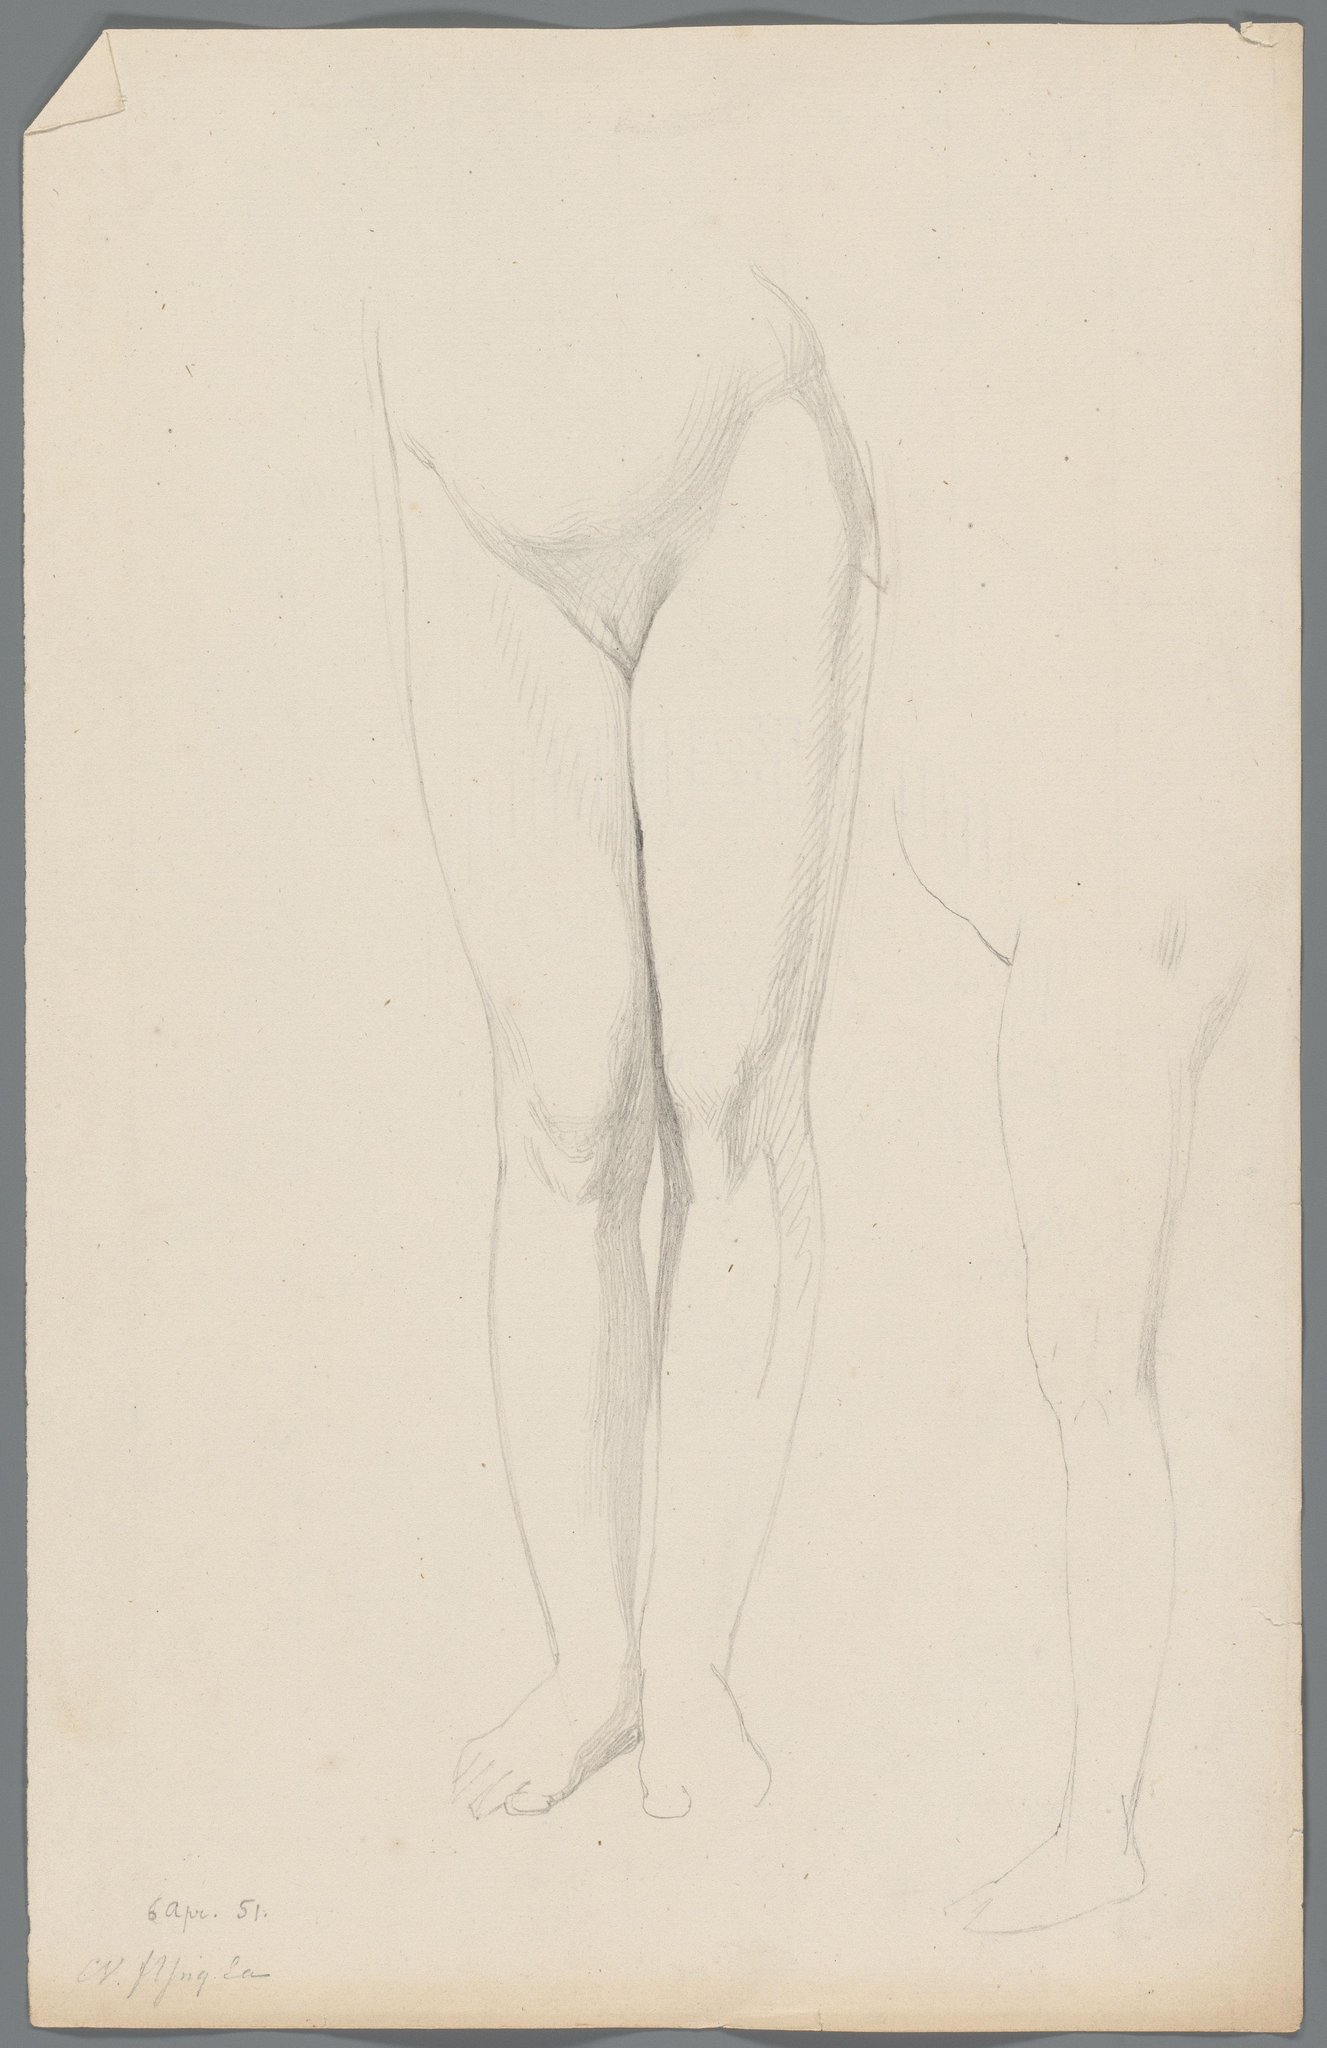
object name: drawing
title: Studie van het onderlichaam van een vrouw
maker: jacobus everhardus josephus van den berg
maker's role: draughtsman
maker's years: 1802-1861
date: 1851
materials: paper, pencil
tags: legs - aa - female human figure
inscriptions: inscription: ‘6 apr 51’